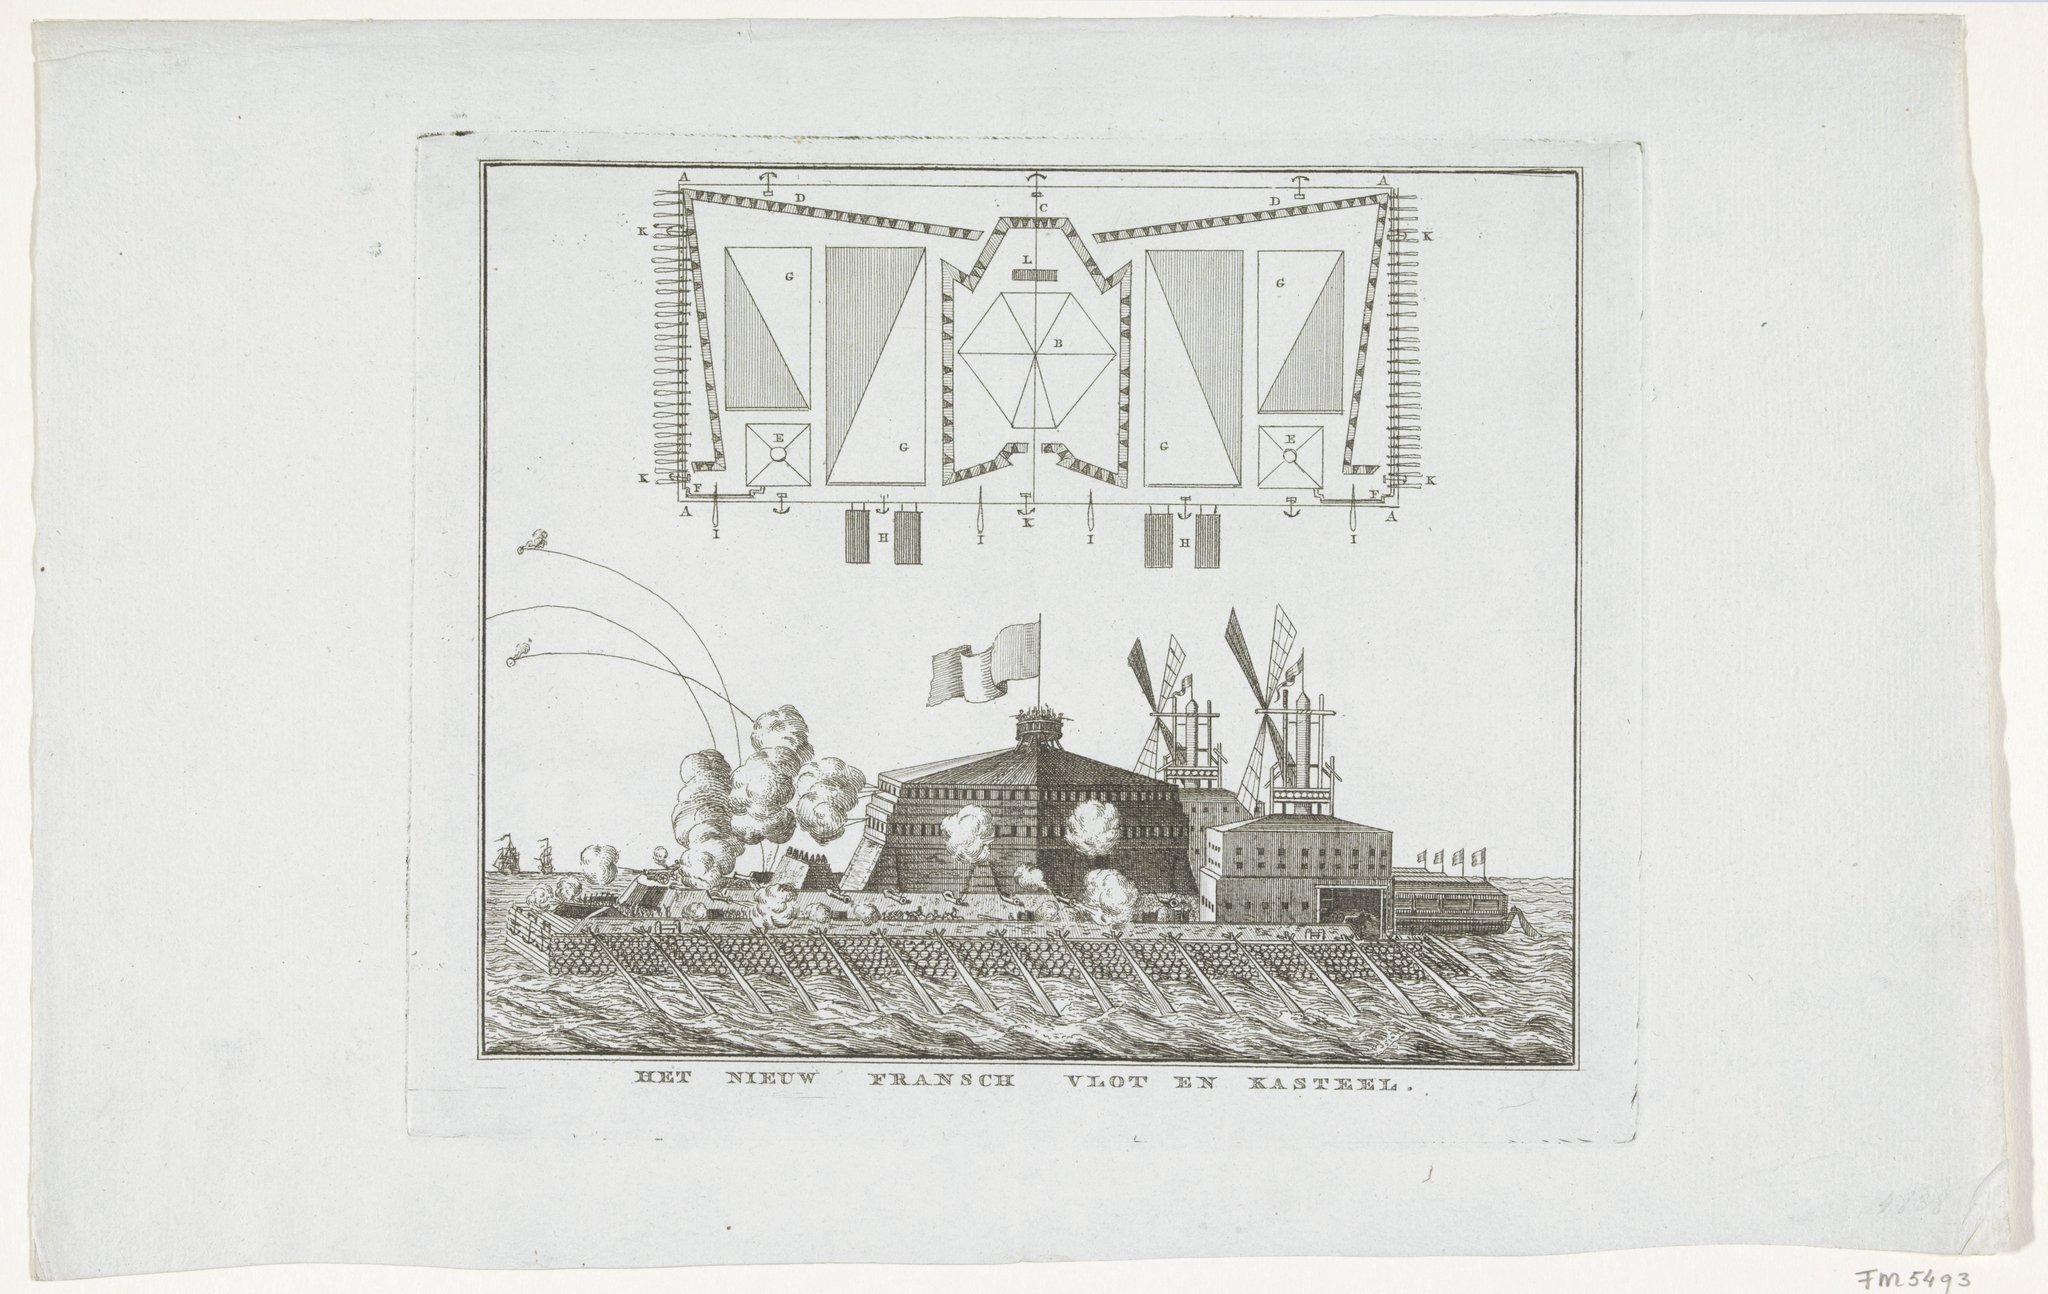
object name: print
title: Vlot van Saint-Malo, 1797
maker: Anonymous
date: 1797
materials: paper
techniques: engraving, etching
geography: netherlands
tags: navy (+ naval force), raft (+ propulsion of vehicle, ship, etc. by wind)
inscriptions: collector's mark: Lugt 2228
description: Frans vlot of drijvend kasteel waarmee 15.000 met paarden en geschut getransporteerd moesten kunnen worden. Ontworpen door de Franse ingenieur Le Blanc voor de invasie van Engeland vanuit Frankrijk, februari 1797. Centraal op het vlot een vesting of kasteel. In dit ontwerp aan de achterzijde molens op wind- of paardenkracht waarmee raderen in het water of riemen aan de zijden aangedreven kunnen worden. Bovenaan een plattegrond van de constructie. Bij de plaat behoort een tekstblad met uitleg.